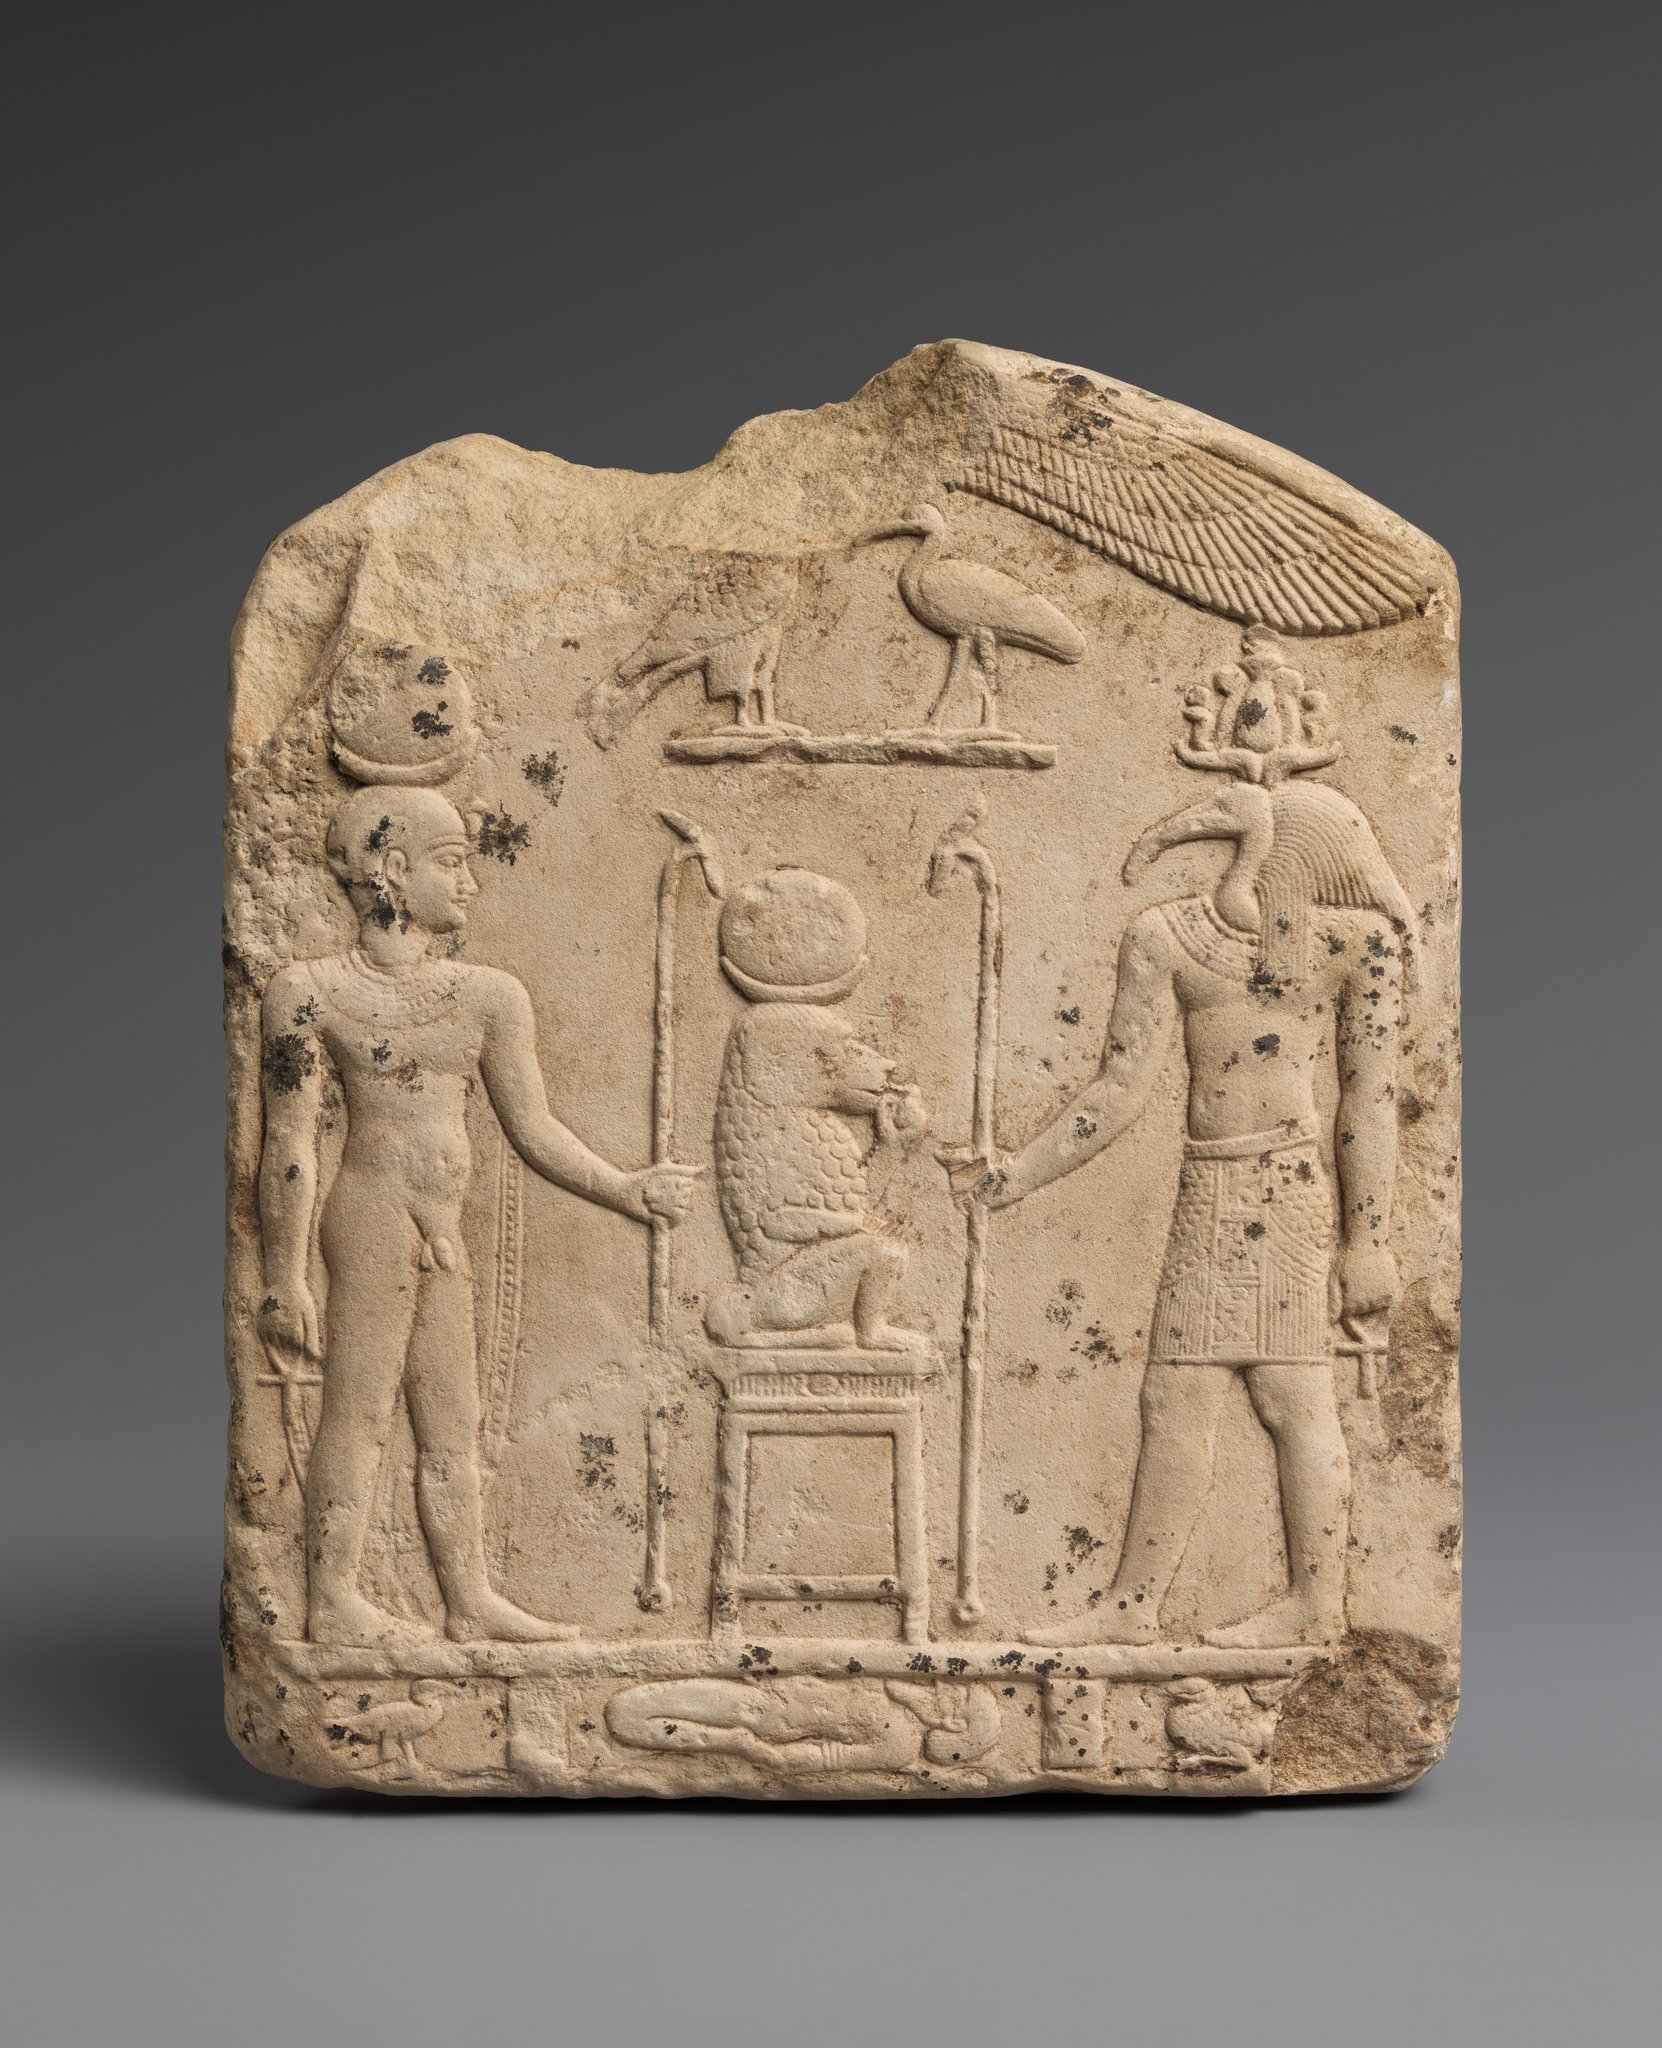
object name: stela, pluriform thoth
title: Two-sided stela of pluriform Thoth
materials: limestone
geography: egypt